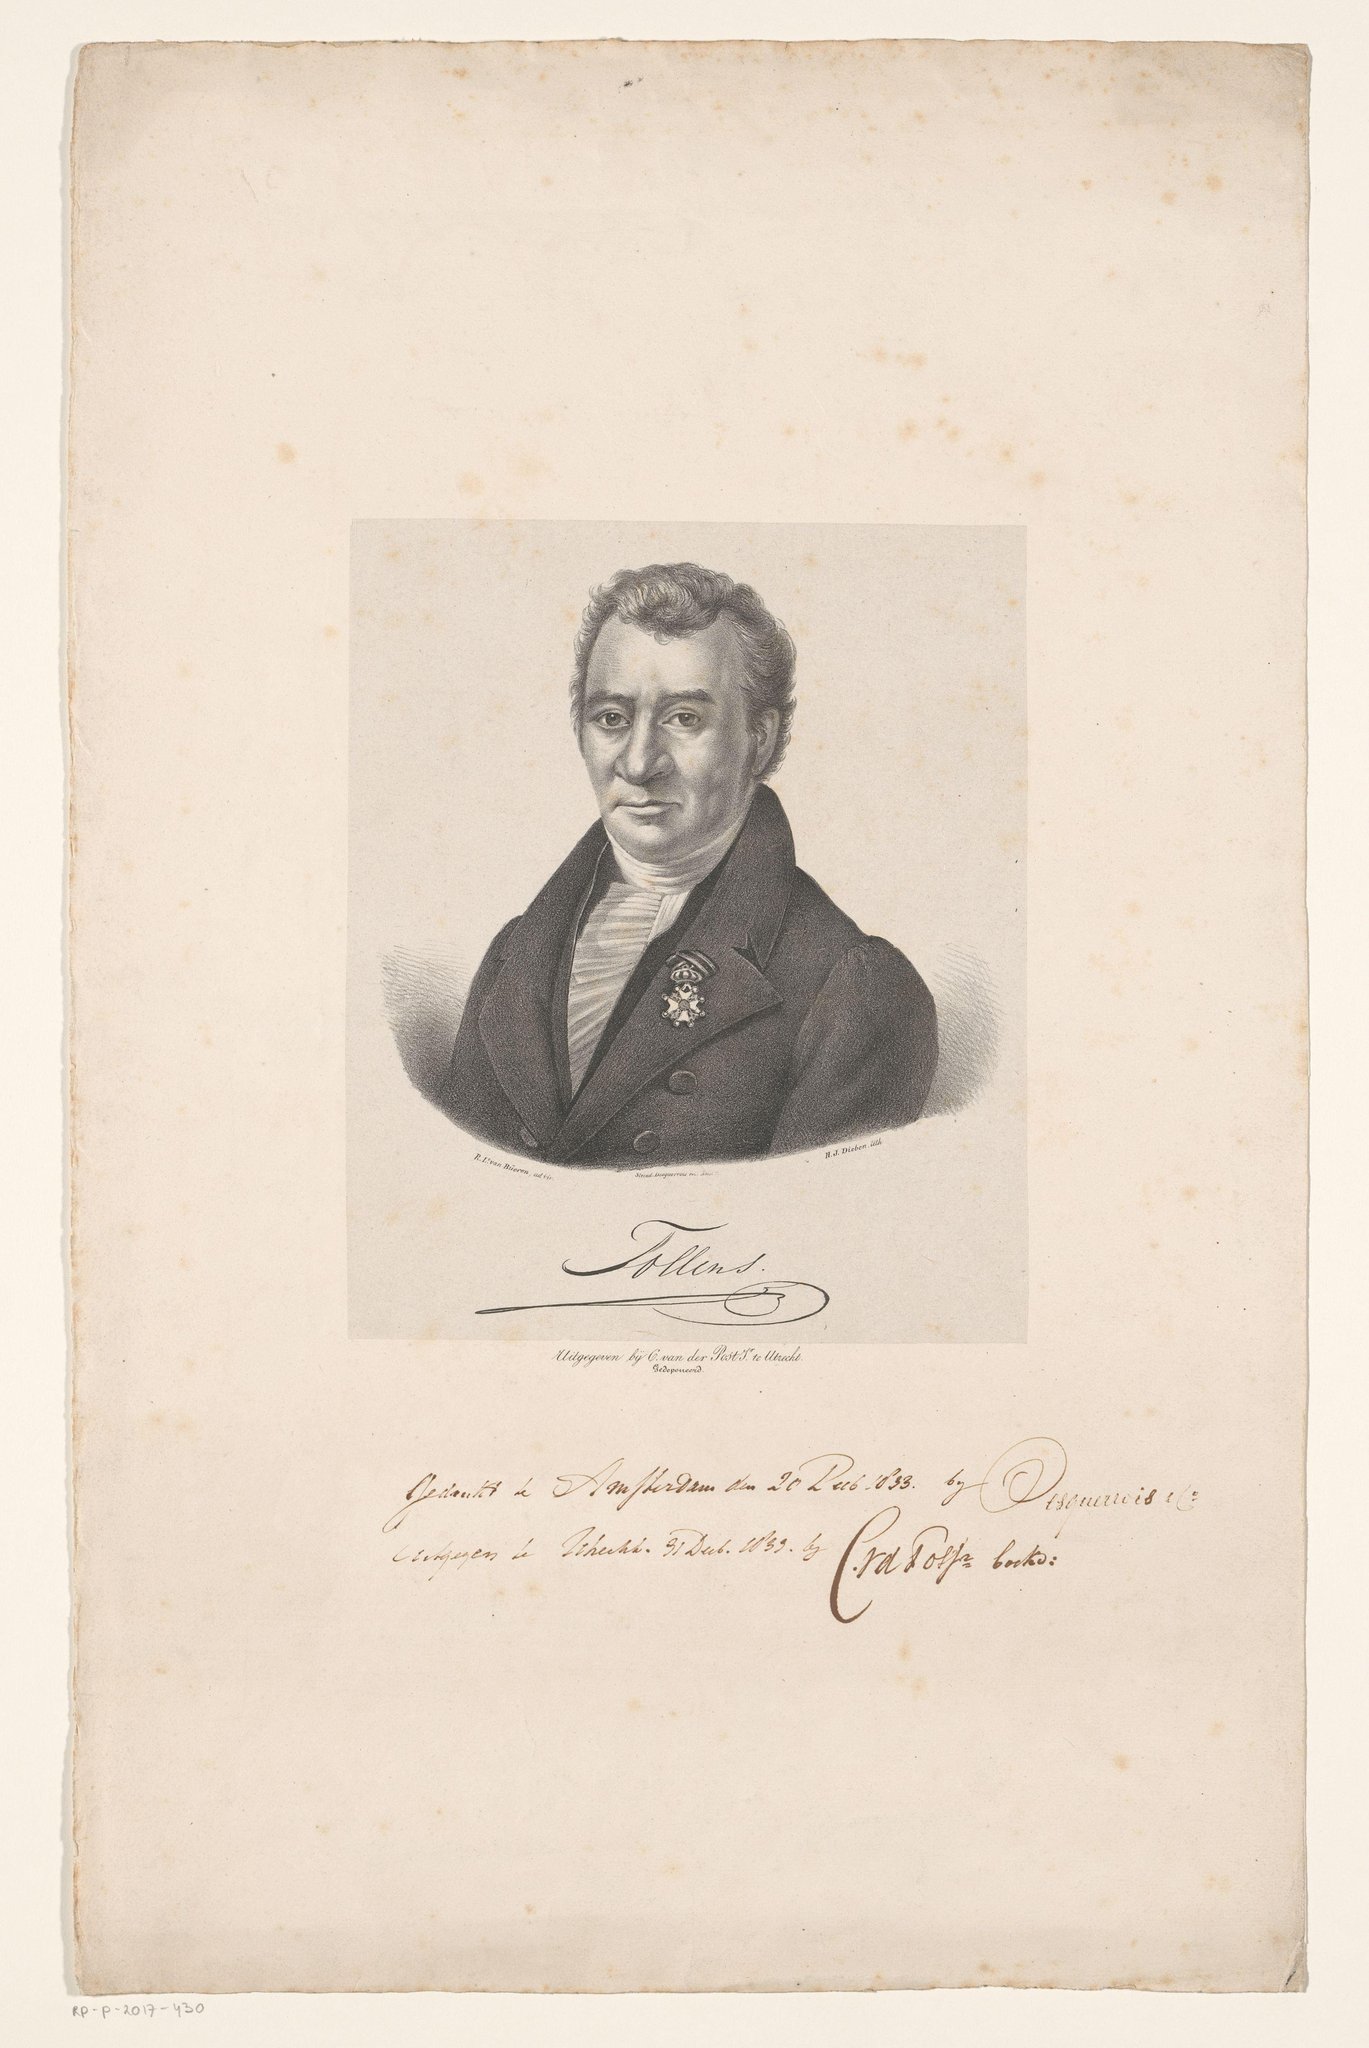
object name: print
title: Portret van Hendrik Tollens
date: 1833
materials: paper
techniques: lithograph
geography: amsterdam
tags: rotterdam, hendrik tollens, knighthood order, historical persons (+ (full) bust portrait)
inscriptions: : ‘Uitgegeven te Utrecht 31 dec 1833 by C. vd Post jr. (...)’, : ‘Gedeponeerd.’, : ‘Gedrukt te Amsterdam den 20 Dec 1833 bij Desguerrois & Co’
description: De geportretteerde draagt een geplooide bef en een ridderorde op de revers van zijn jas. Onder het portret zijn signatuur.